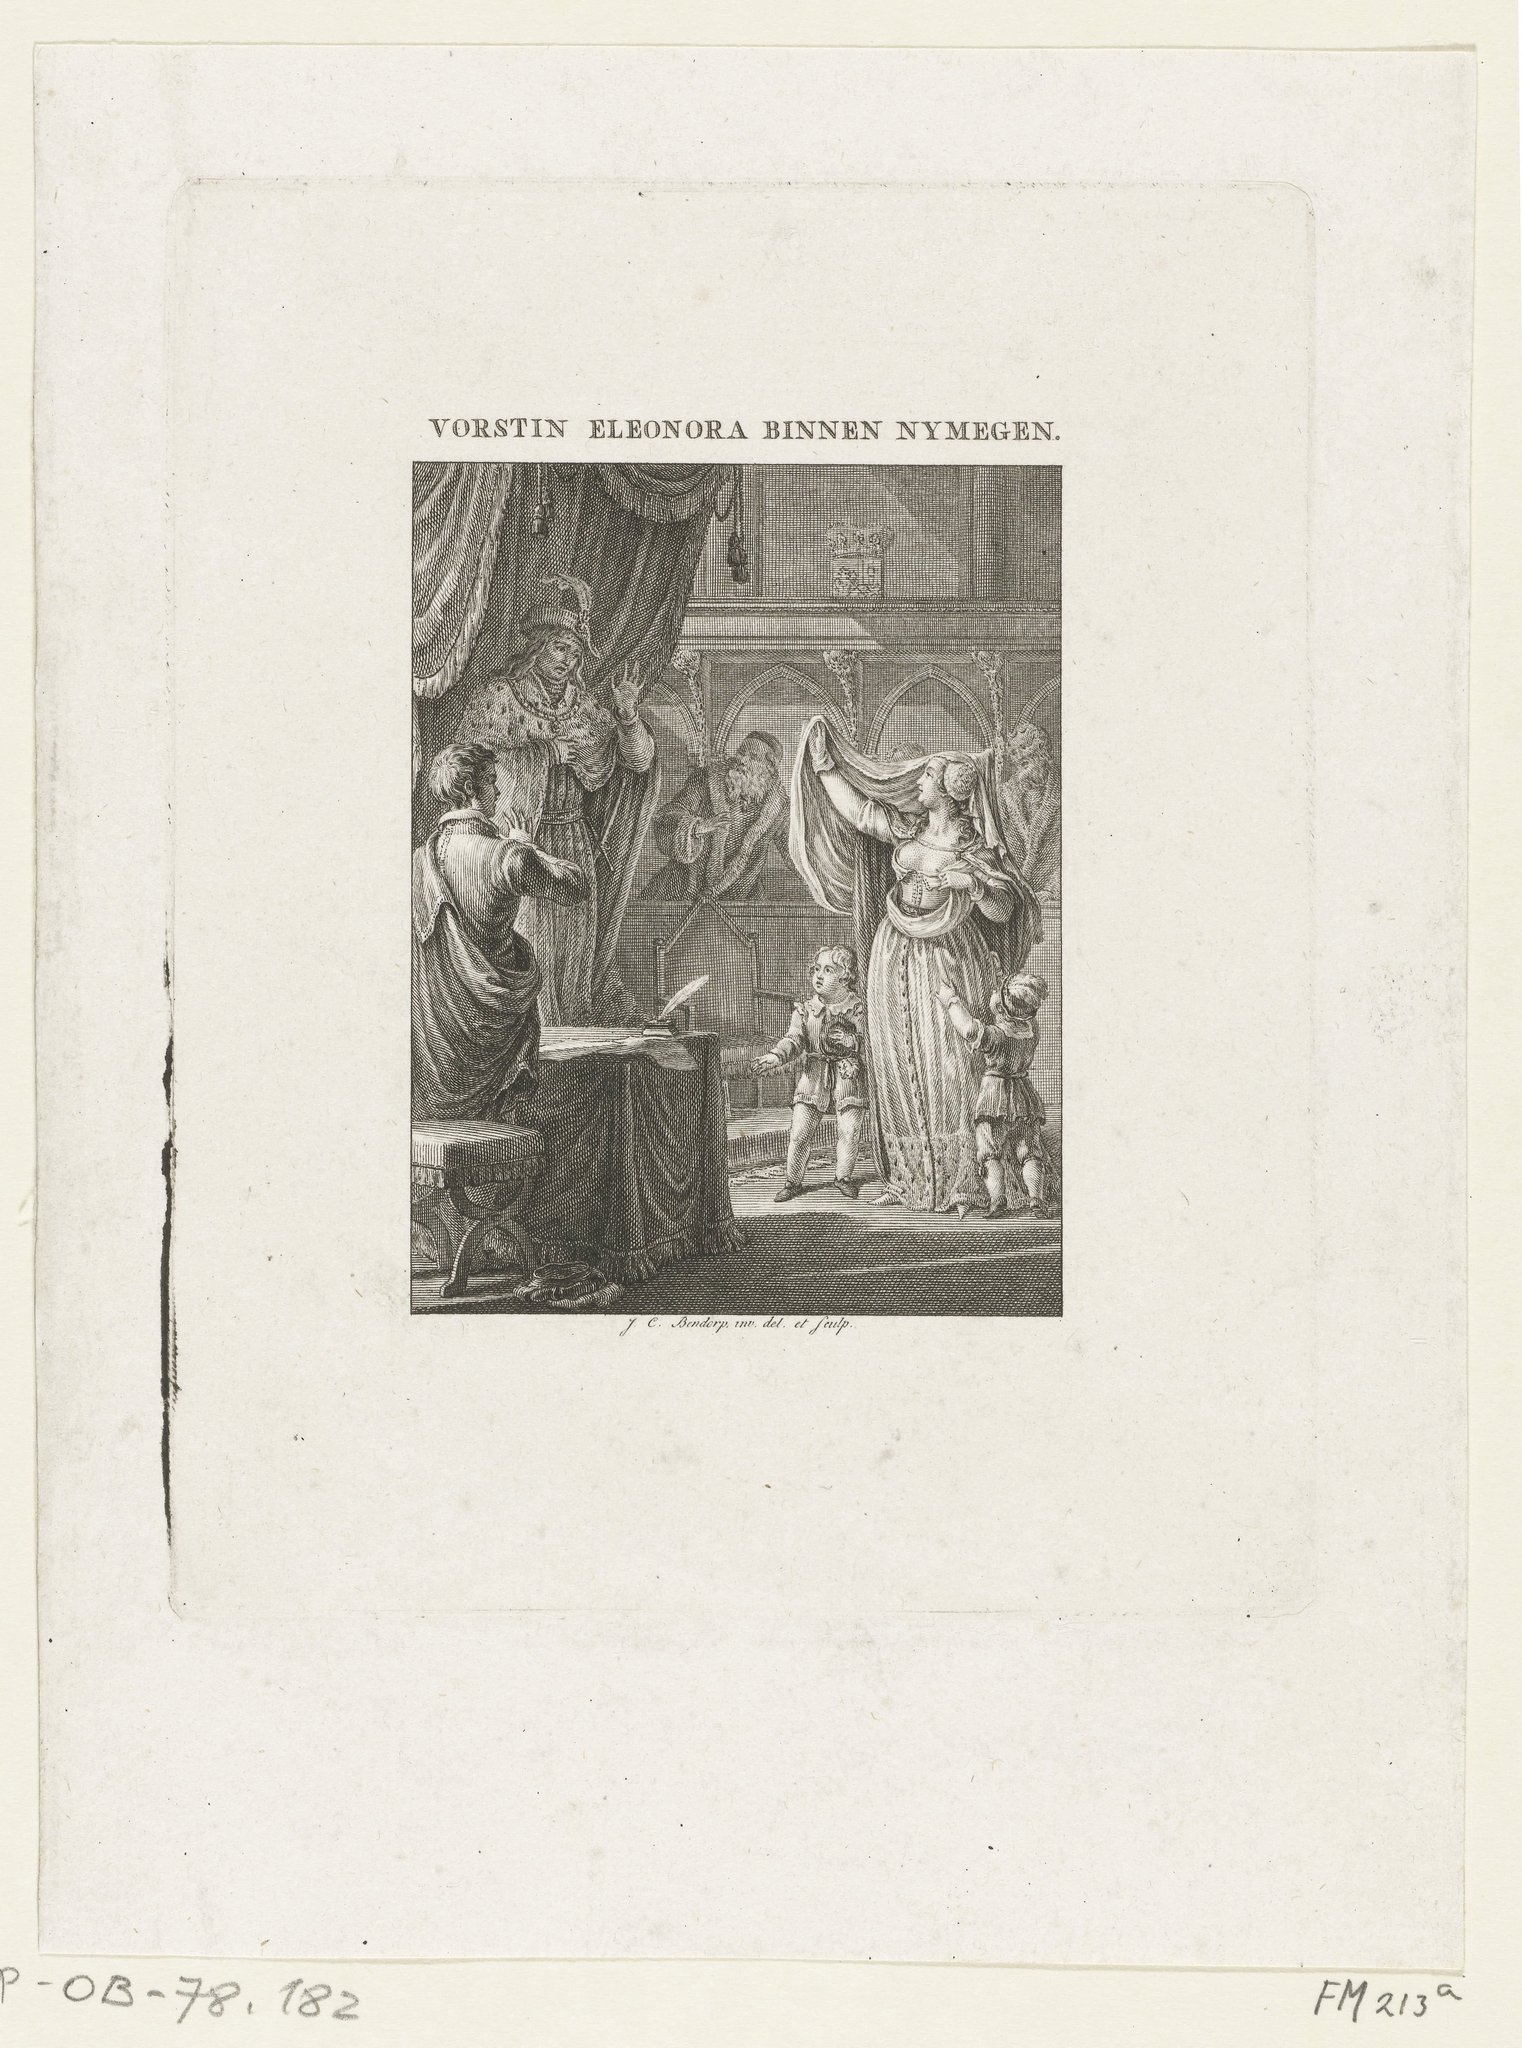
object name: print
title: Eleonora verwijt graaf Reinoud II van Gelre zijn verwijdering, 1342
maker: johannes christiaan bendorp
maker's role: print maker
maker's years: 1766-1849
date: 1821-1823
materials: paper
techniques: etching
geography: netherlands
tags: arnhem, deventer, nijmegen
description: Eleonora van Engeland verwijt in Nijmegen haar man graaf Reinoud II van Gelre zijn verwijdering in het jaar 1342. Zij bewijst haar man dat zij niet melaats is en dat hij haar dus ten onrechte heeft verstoten. Zij voorspelt de ondergang van zijn huis, beide zonen die naast haar staan, zullen sneuvelen in de strijd om hun vaders naam.